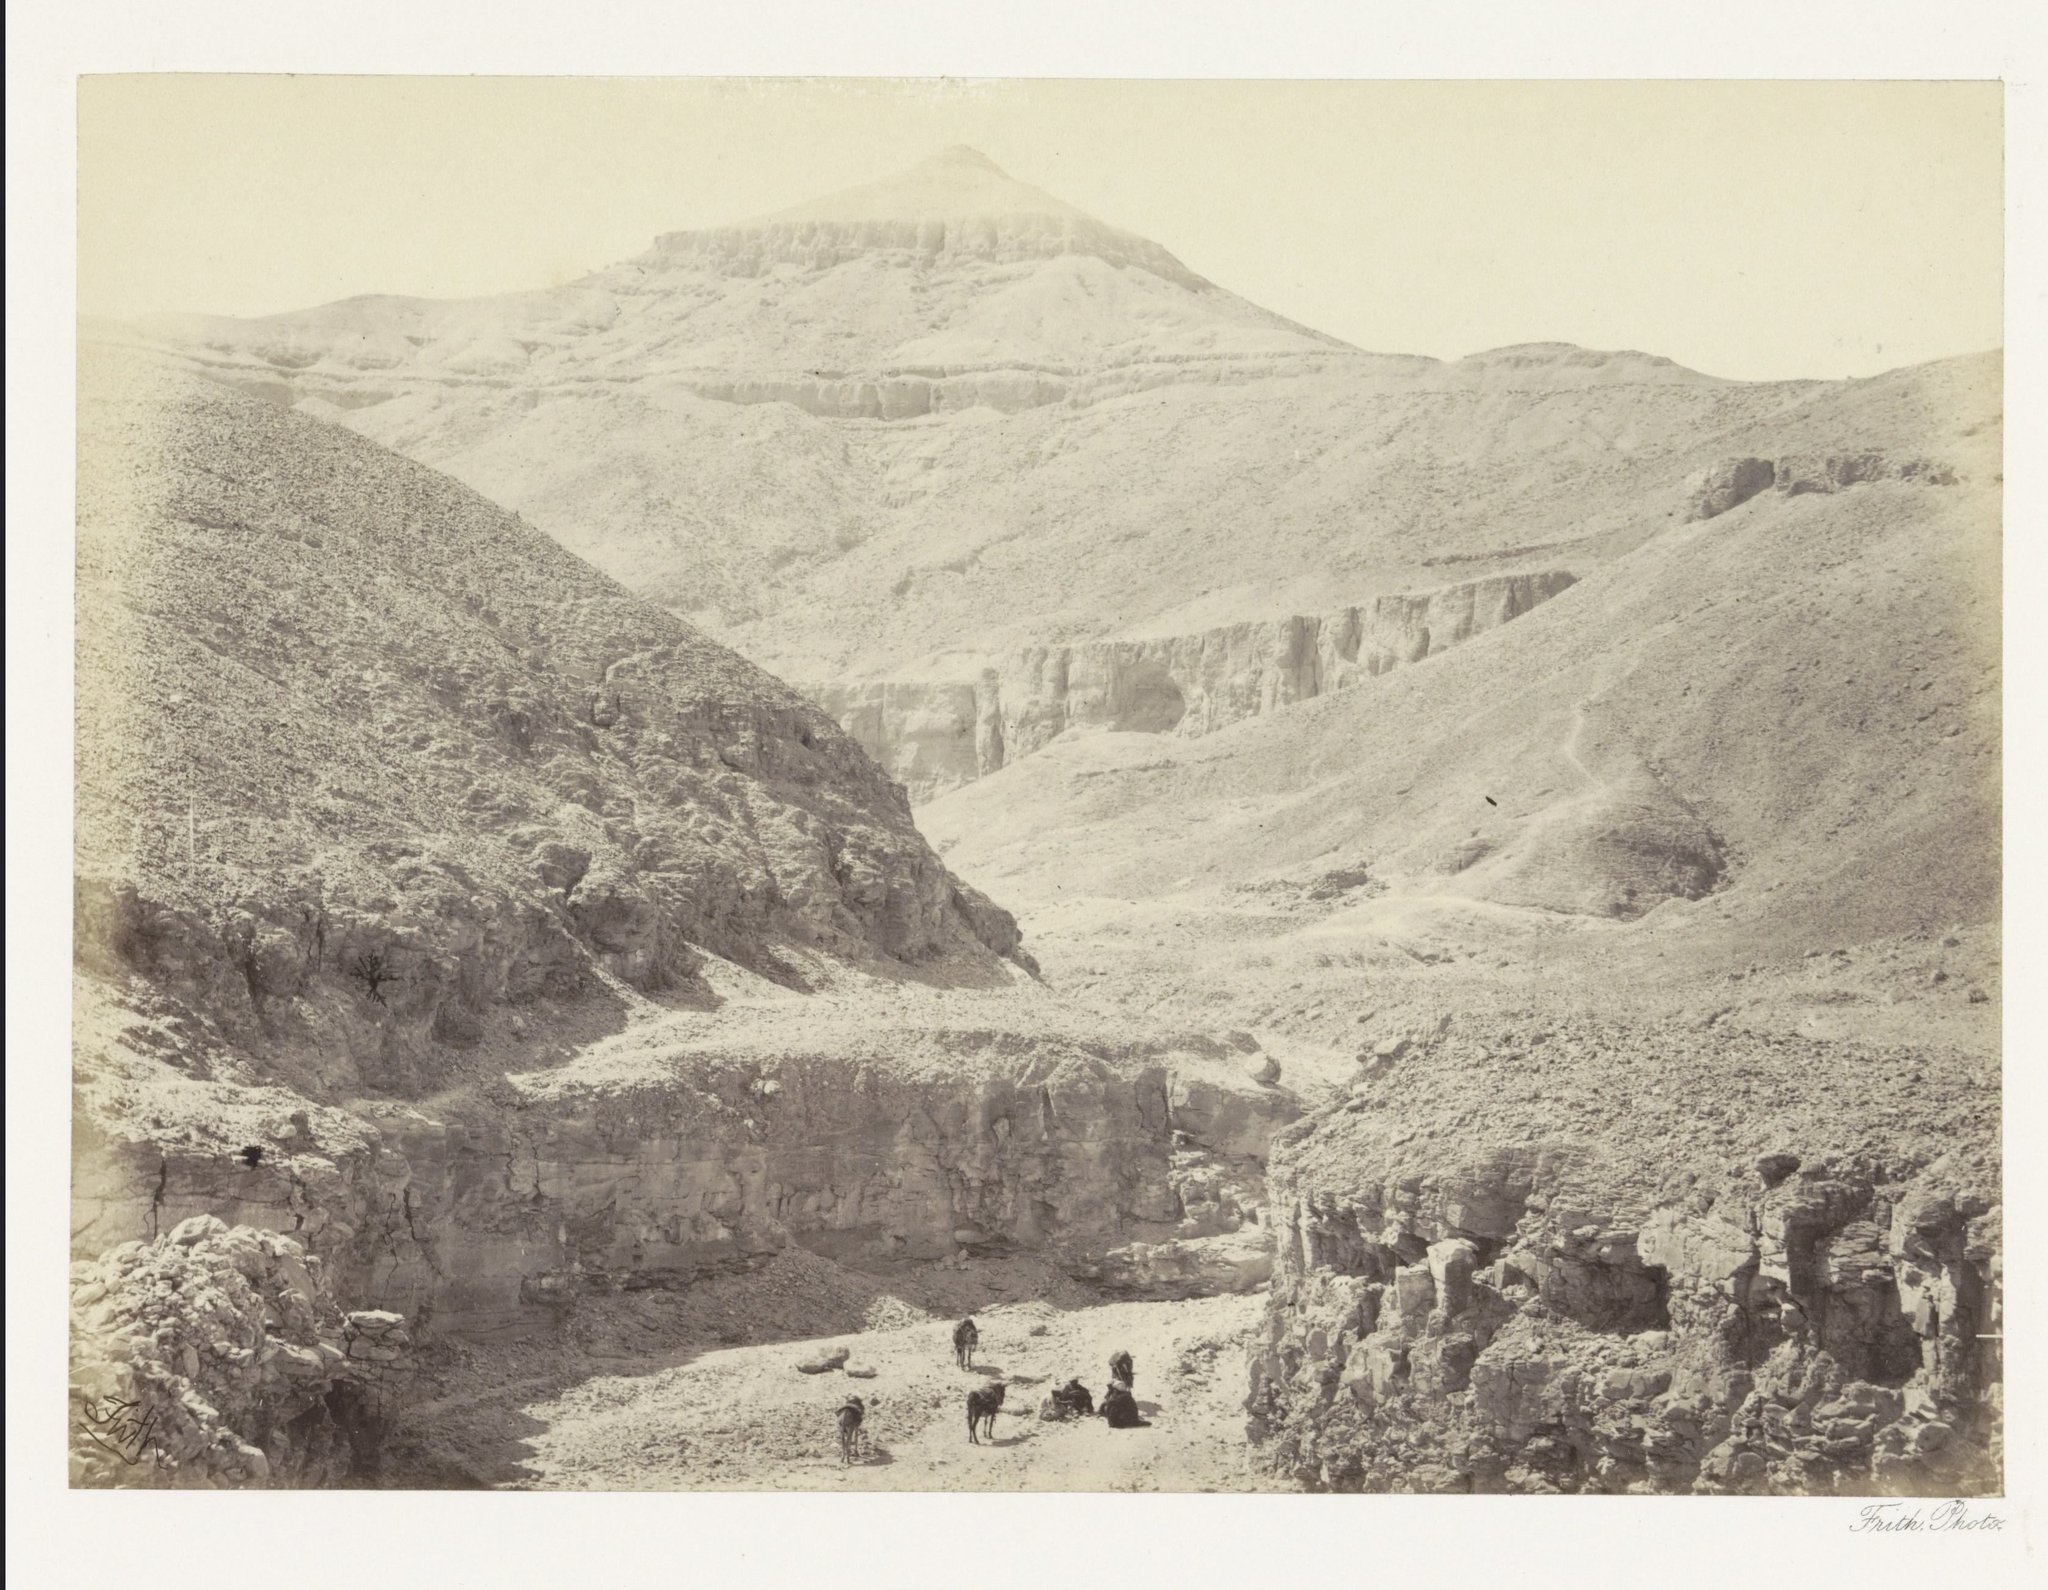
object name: page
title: Vallei der Koningen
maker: francis frith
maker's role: publisher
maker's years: 1822-1898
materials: paper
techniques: albumen print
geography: thebes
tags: dale, valley, cult of the dead